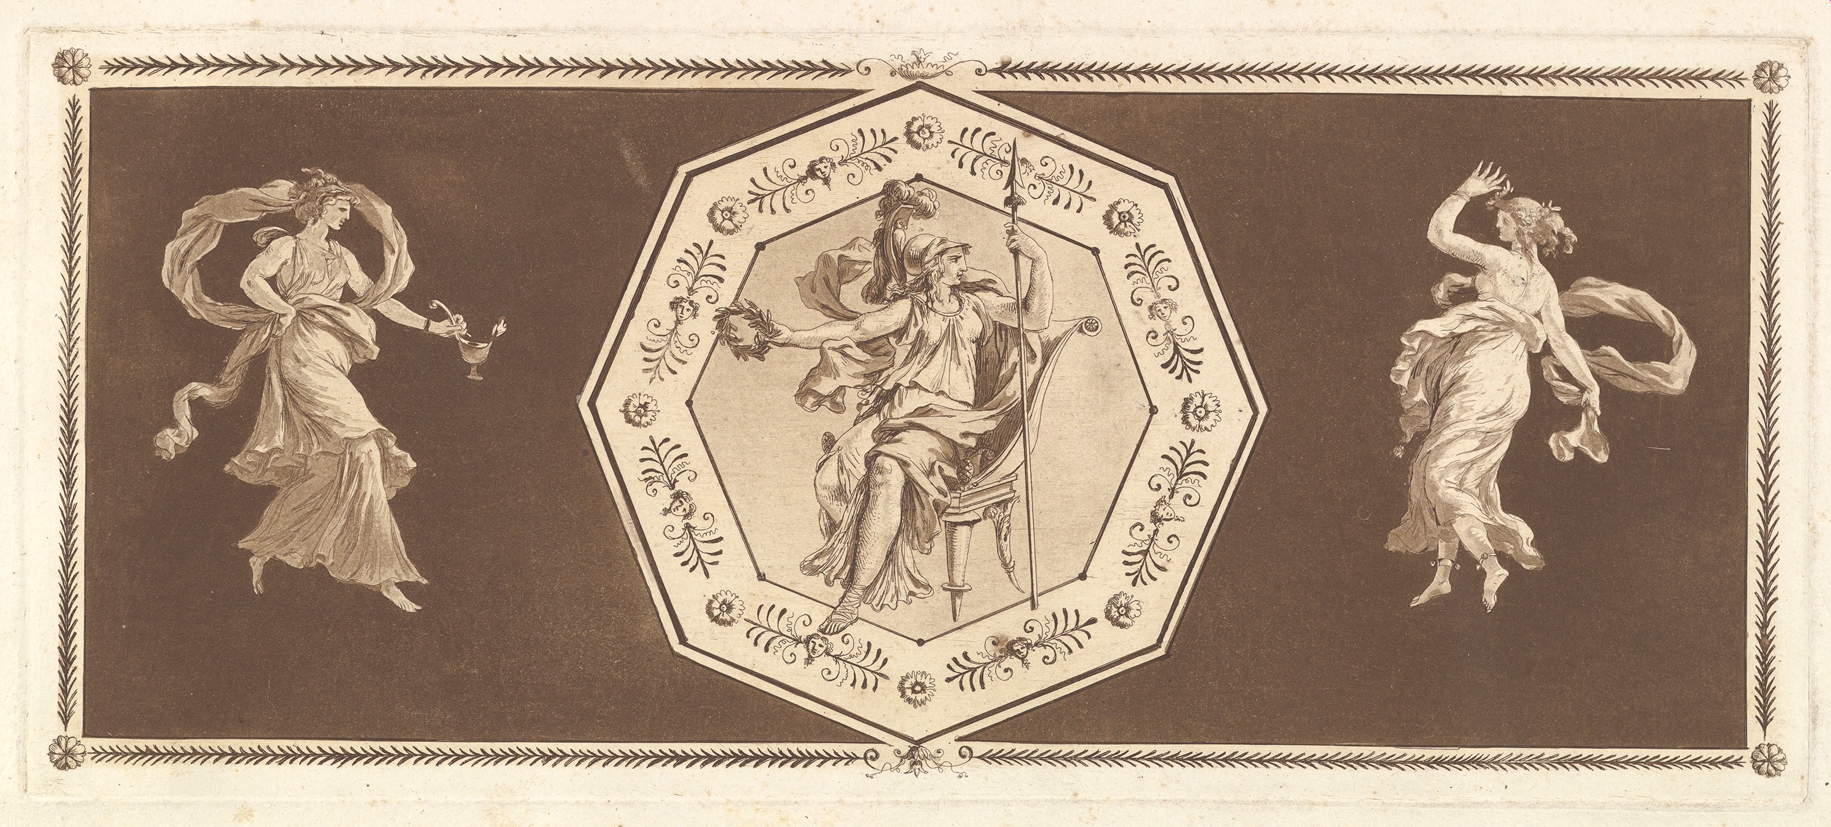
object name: print collection ornament architecture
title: Minerve assisse dans un octagone décoratif, avec une figure à gauche et à doroite (la Nuit et le Jour?) (Minerva seated within an octagonal border, wth a figure at the right and at the left (Night and Day?), from Recueil de Différentes Compositions Frises et Ornements dessinées et gravées à la manière du lavis par La Grenée le Juene Se trouve chez l'Auteur, au Louvre et chez Basan, rue et Hôtel Serpente A Paris, in an album containing Recueil de Compositions par Lagrenée Le Jeune (Collection of Compositions by Lagrenée the Younger)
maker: jean jacques lagrenée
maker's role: artist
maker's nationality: french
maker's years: 1739-1821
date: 1784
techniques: aquatint, etching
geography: france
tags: women,minerva